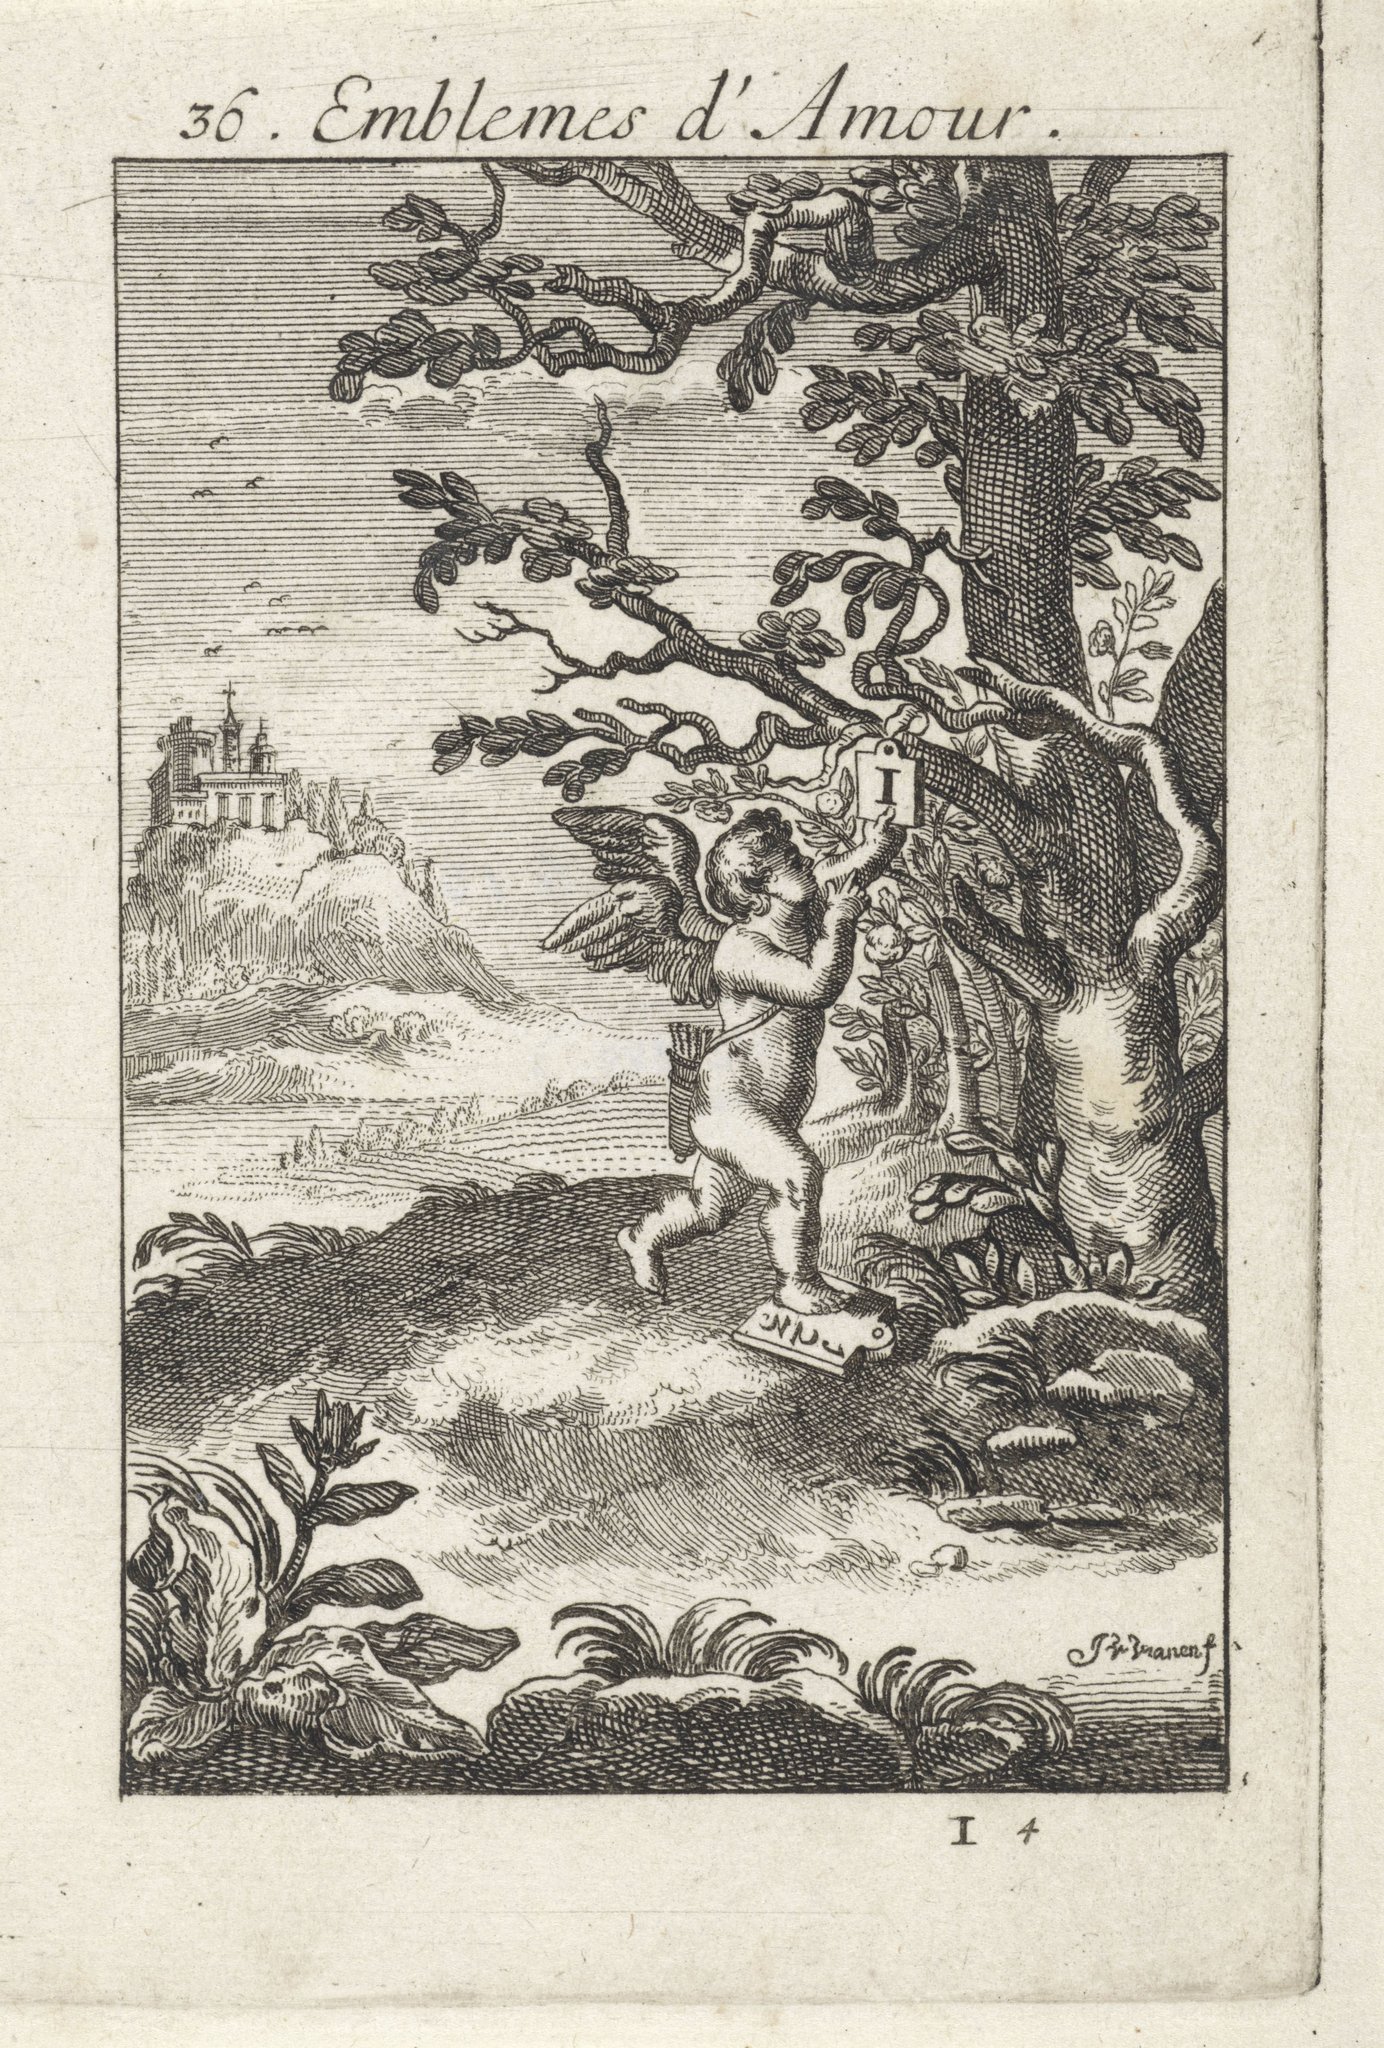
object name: print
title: Emblemes d'Amour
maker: jan van vianen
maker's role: print maker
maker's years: 1660-1726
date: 1686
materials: paper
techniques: etching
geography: northern netherlands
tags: (story of) cupid, amor (eros), numerals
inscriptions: collector's mark: Lugt 2228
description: Amor heeft heeft een bordje met daarop het nummer één in zijn hand en hangt dit in een boom. Onder zijn voet vertrapt hij het bordje met daarop de nummers één, twee en drie. Net zoals een opgesplitste beek zijn kracht in loop verliest, zo verliest verdeelde liefde ook zijn kracht. Zesendertigste embleem uit Emblemata Amatoria.